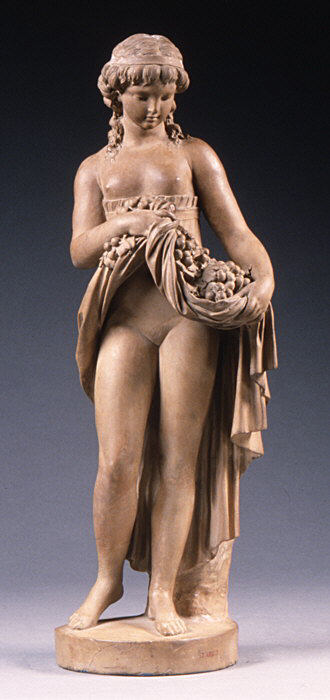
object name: statuette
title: Girl holding fruit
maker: clodion (claude michel)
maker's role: artist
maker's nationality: french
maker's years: 1738-1814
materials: terracotta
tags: fruit,female nudes